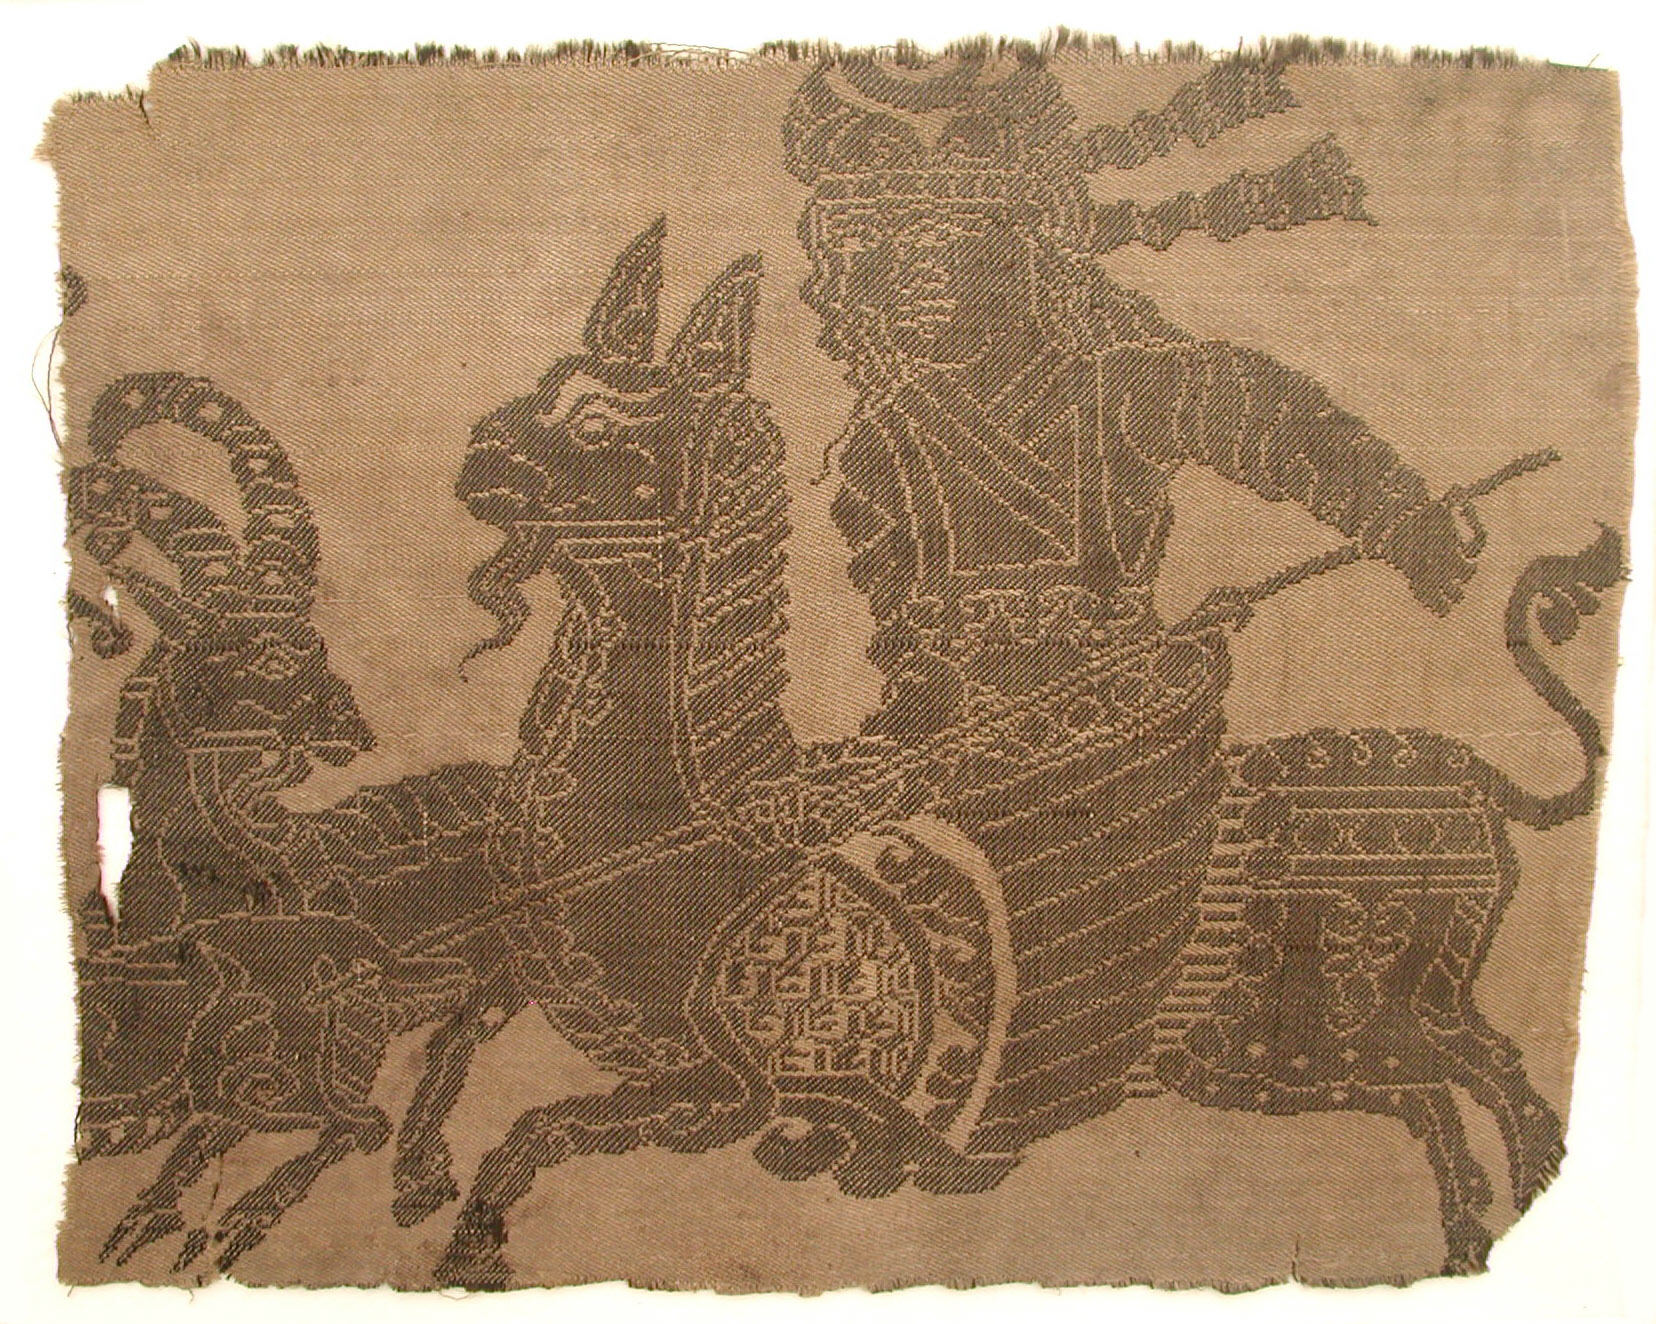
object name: textile fragment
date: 901-1100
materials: silk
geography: iran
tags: human figures,horses